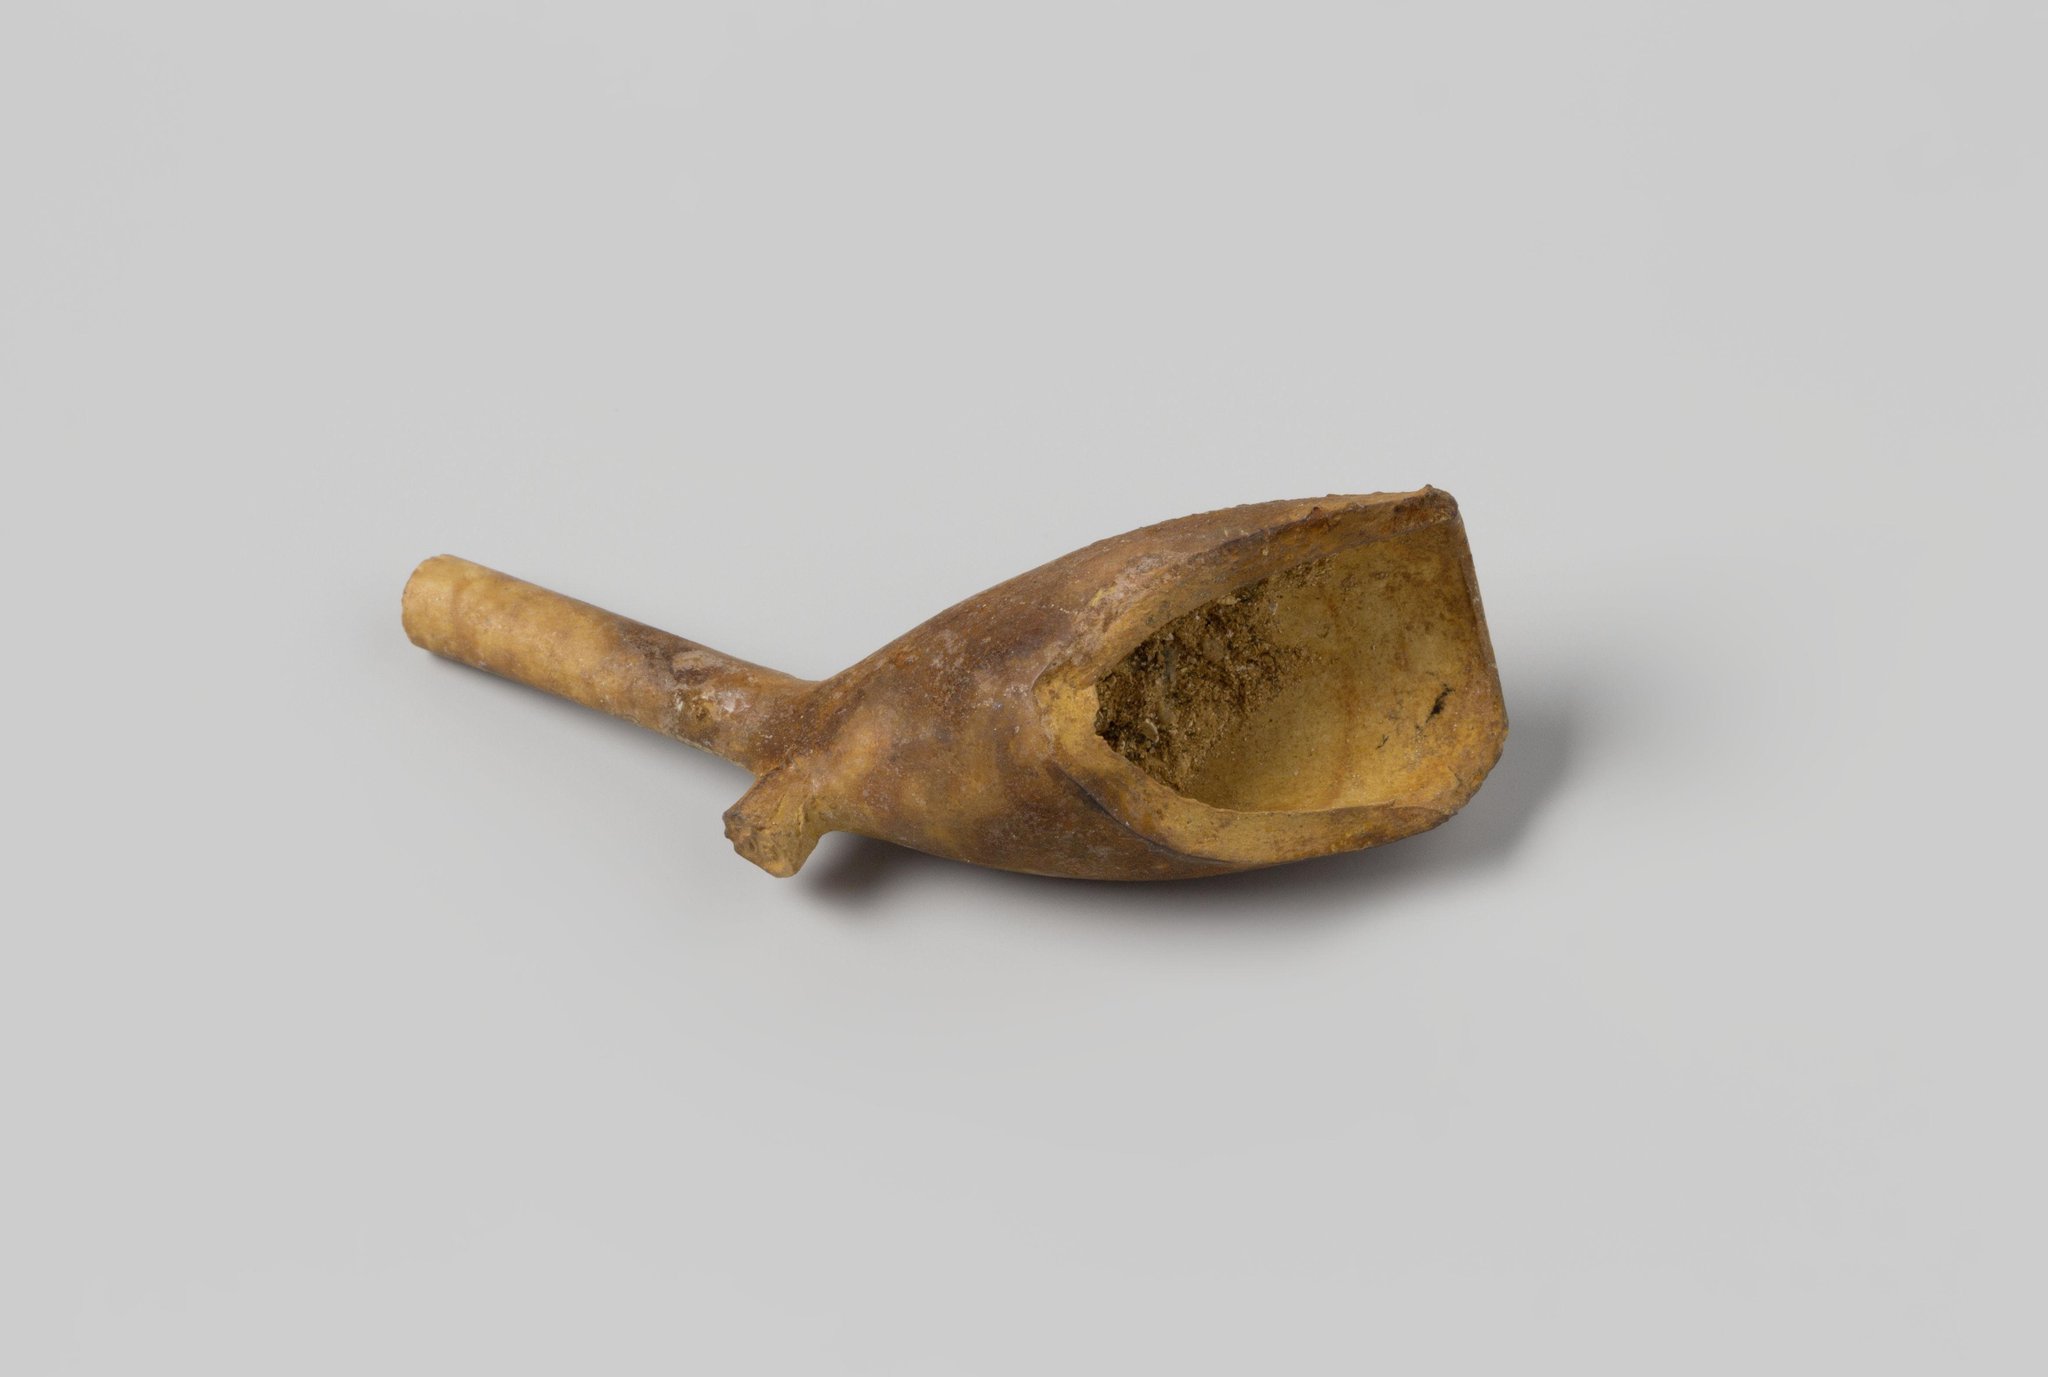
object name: pipe bowl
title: Fragment pijpenkop met stuk steel uit het wrak van de Oost-Indiëvaarder Hollandia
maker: Anonymous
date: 1700-1743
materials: clay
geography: netherlands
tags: verenigde oostindische compagnie, hollandia (schip), annet